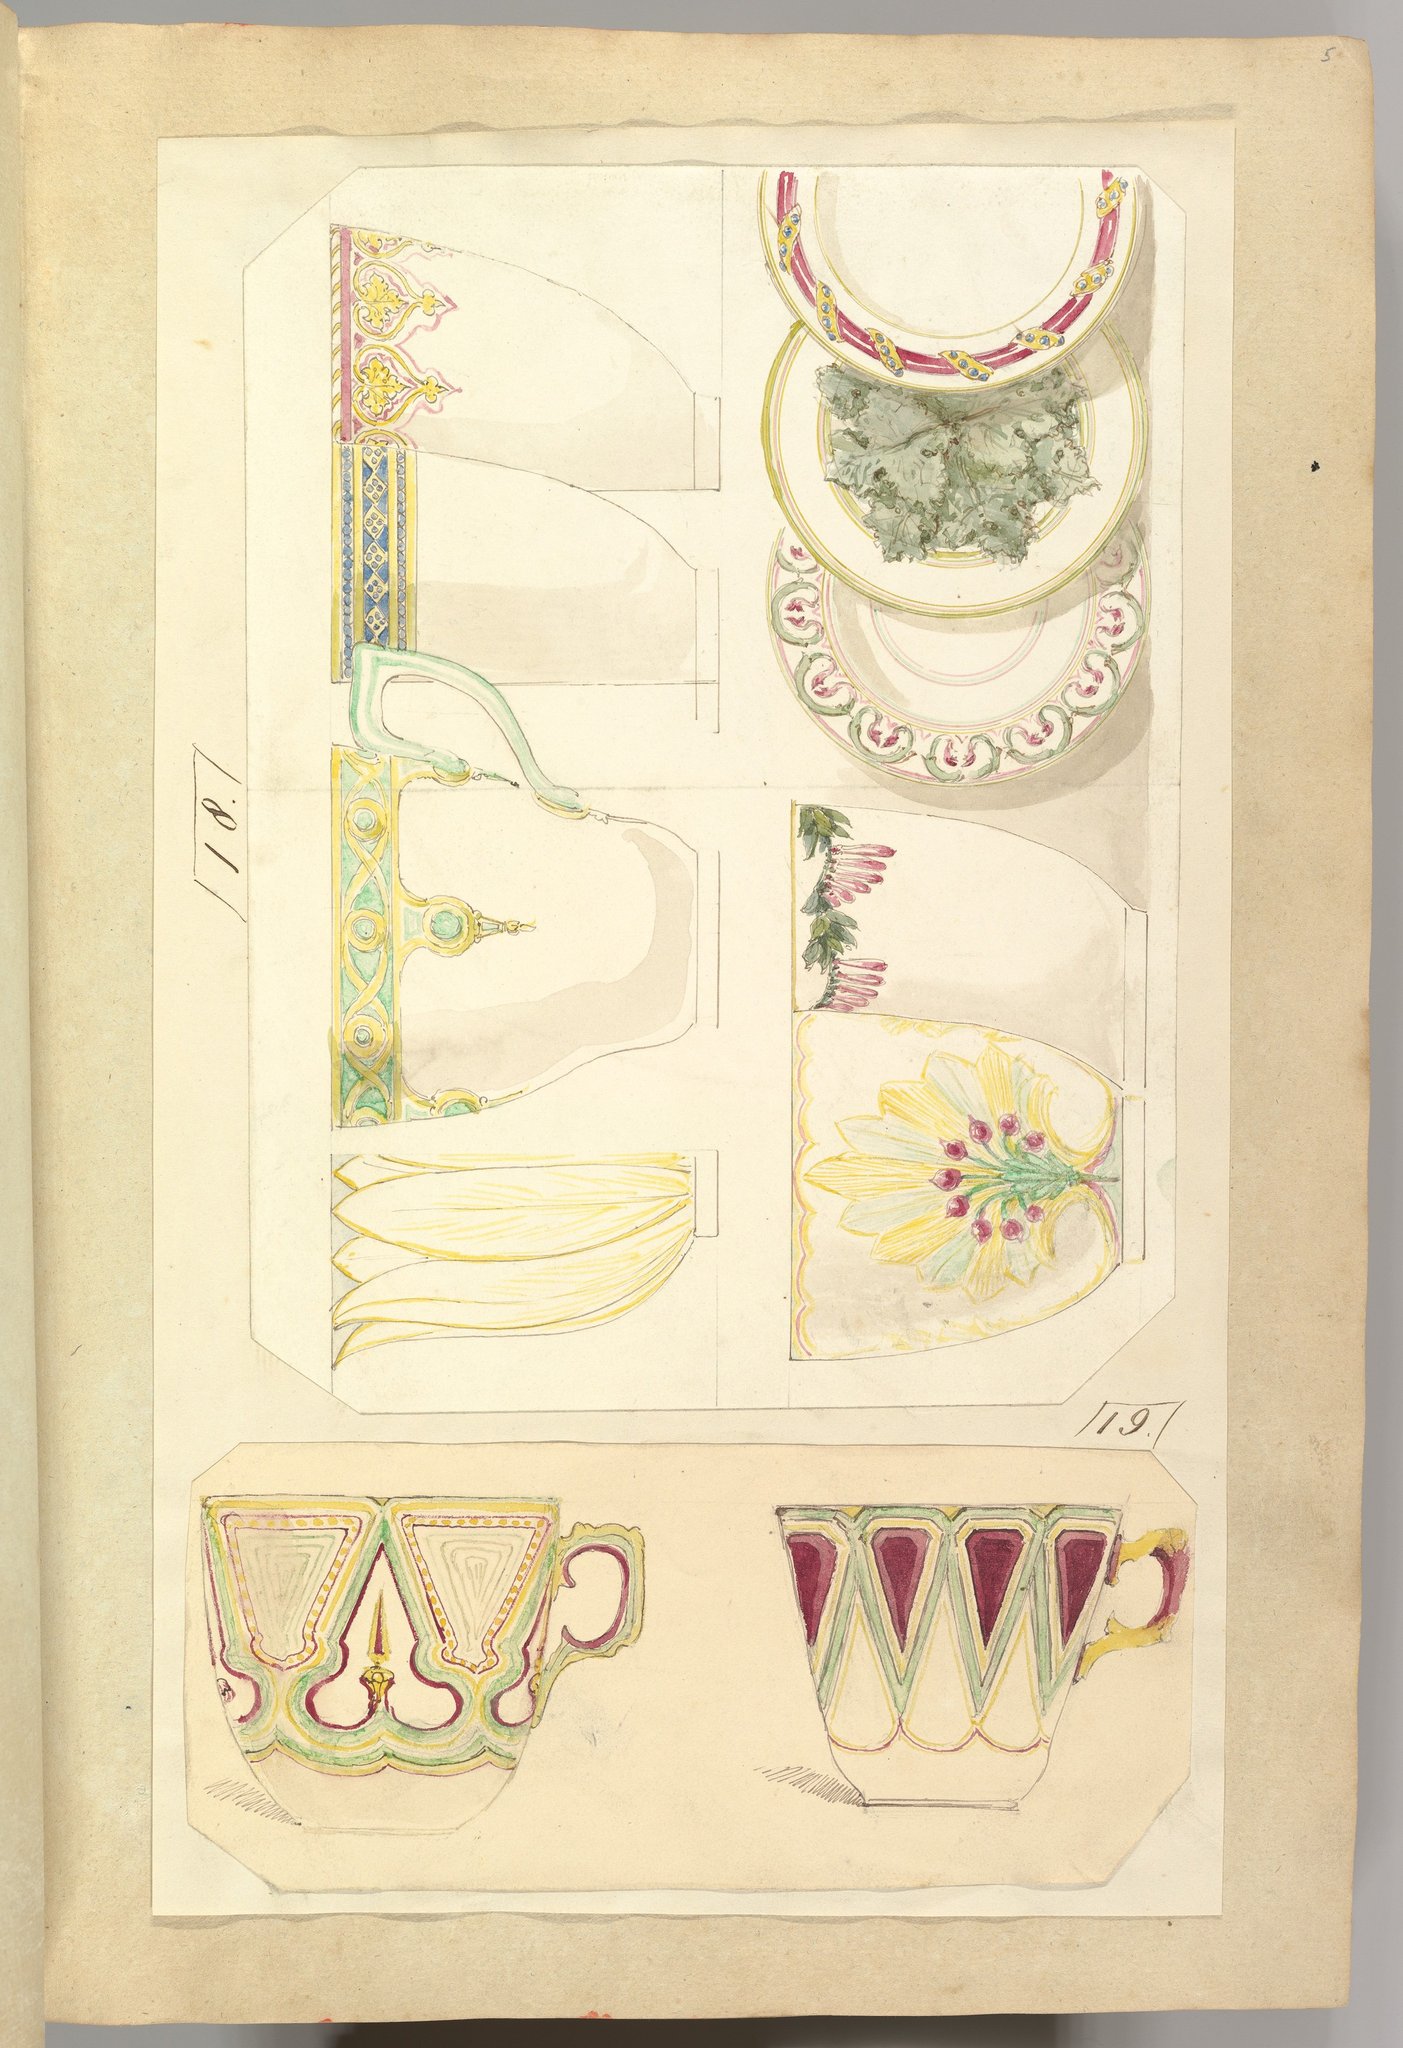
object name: drawing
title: Five Designs for Decorated Cups and Three Designs for Saucers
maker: alfred henry forrester [alfred crowquill]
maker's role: artist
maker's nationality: british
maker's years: 1804-1872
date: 1845-1855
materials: gouache, ink, watercolor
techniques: pen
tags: cups,saucers